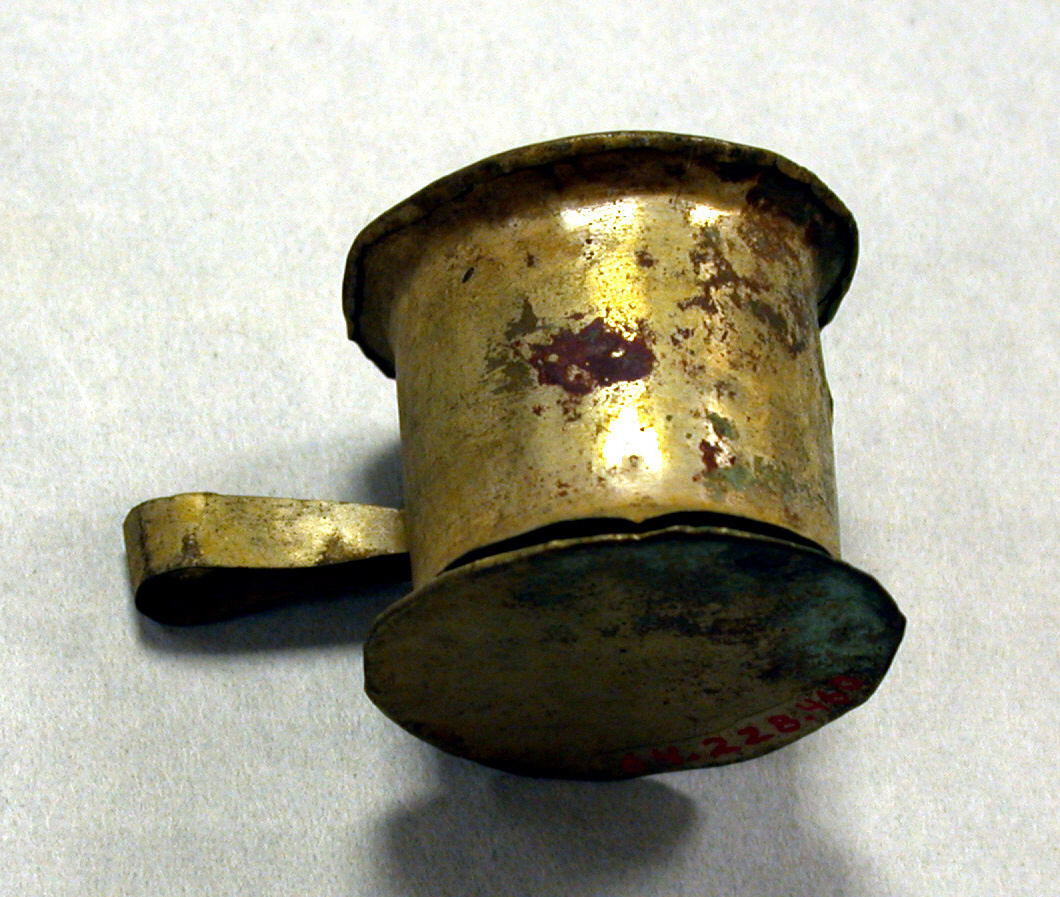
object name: drum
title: Hammered Silver Miniature Drum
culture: chancay or chimú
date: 1001-1466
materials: gilt, silver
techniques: hammering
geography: peru